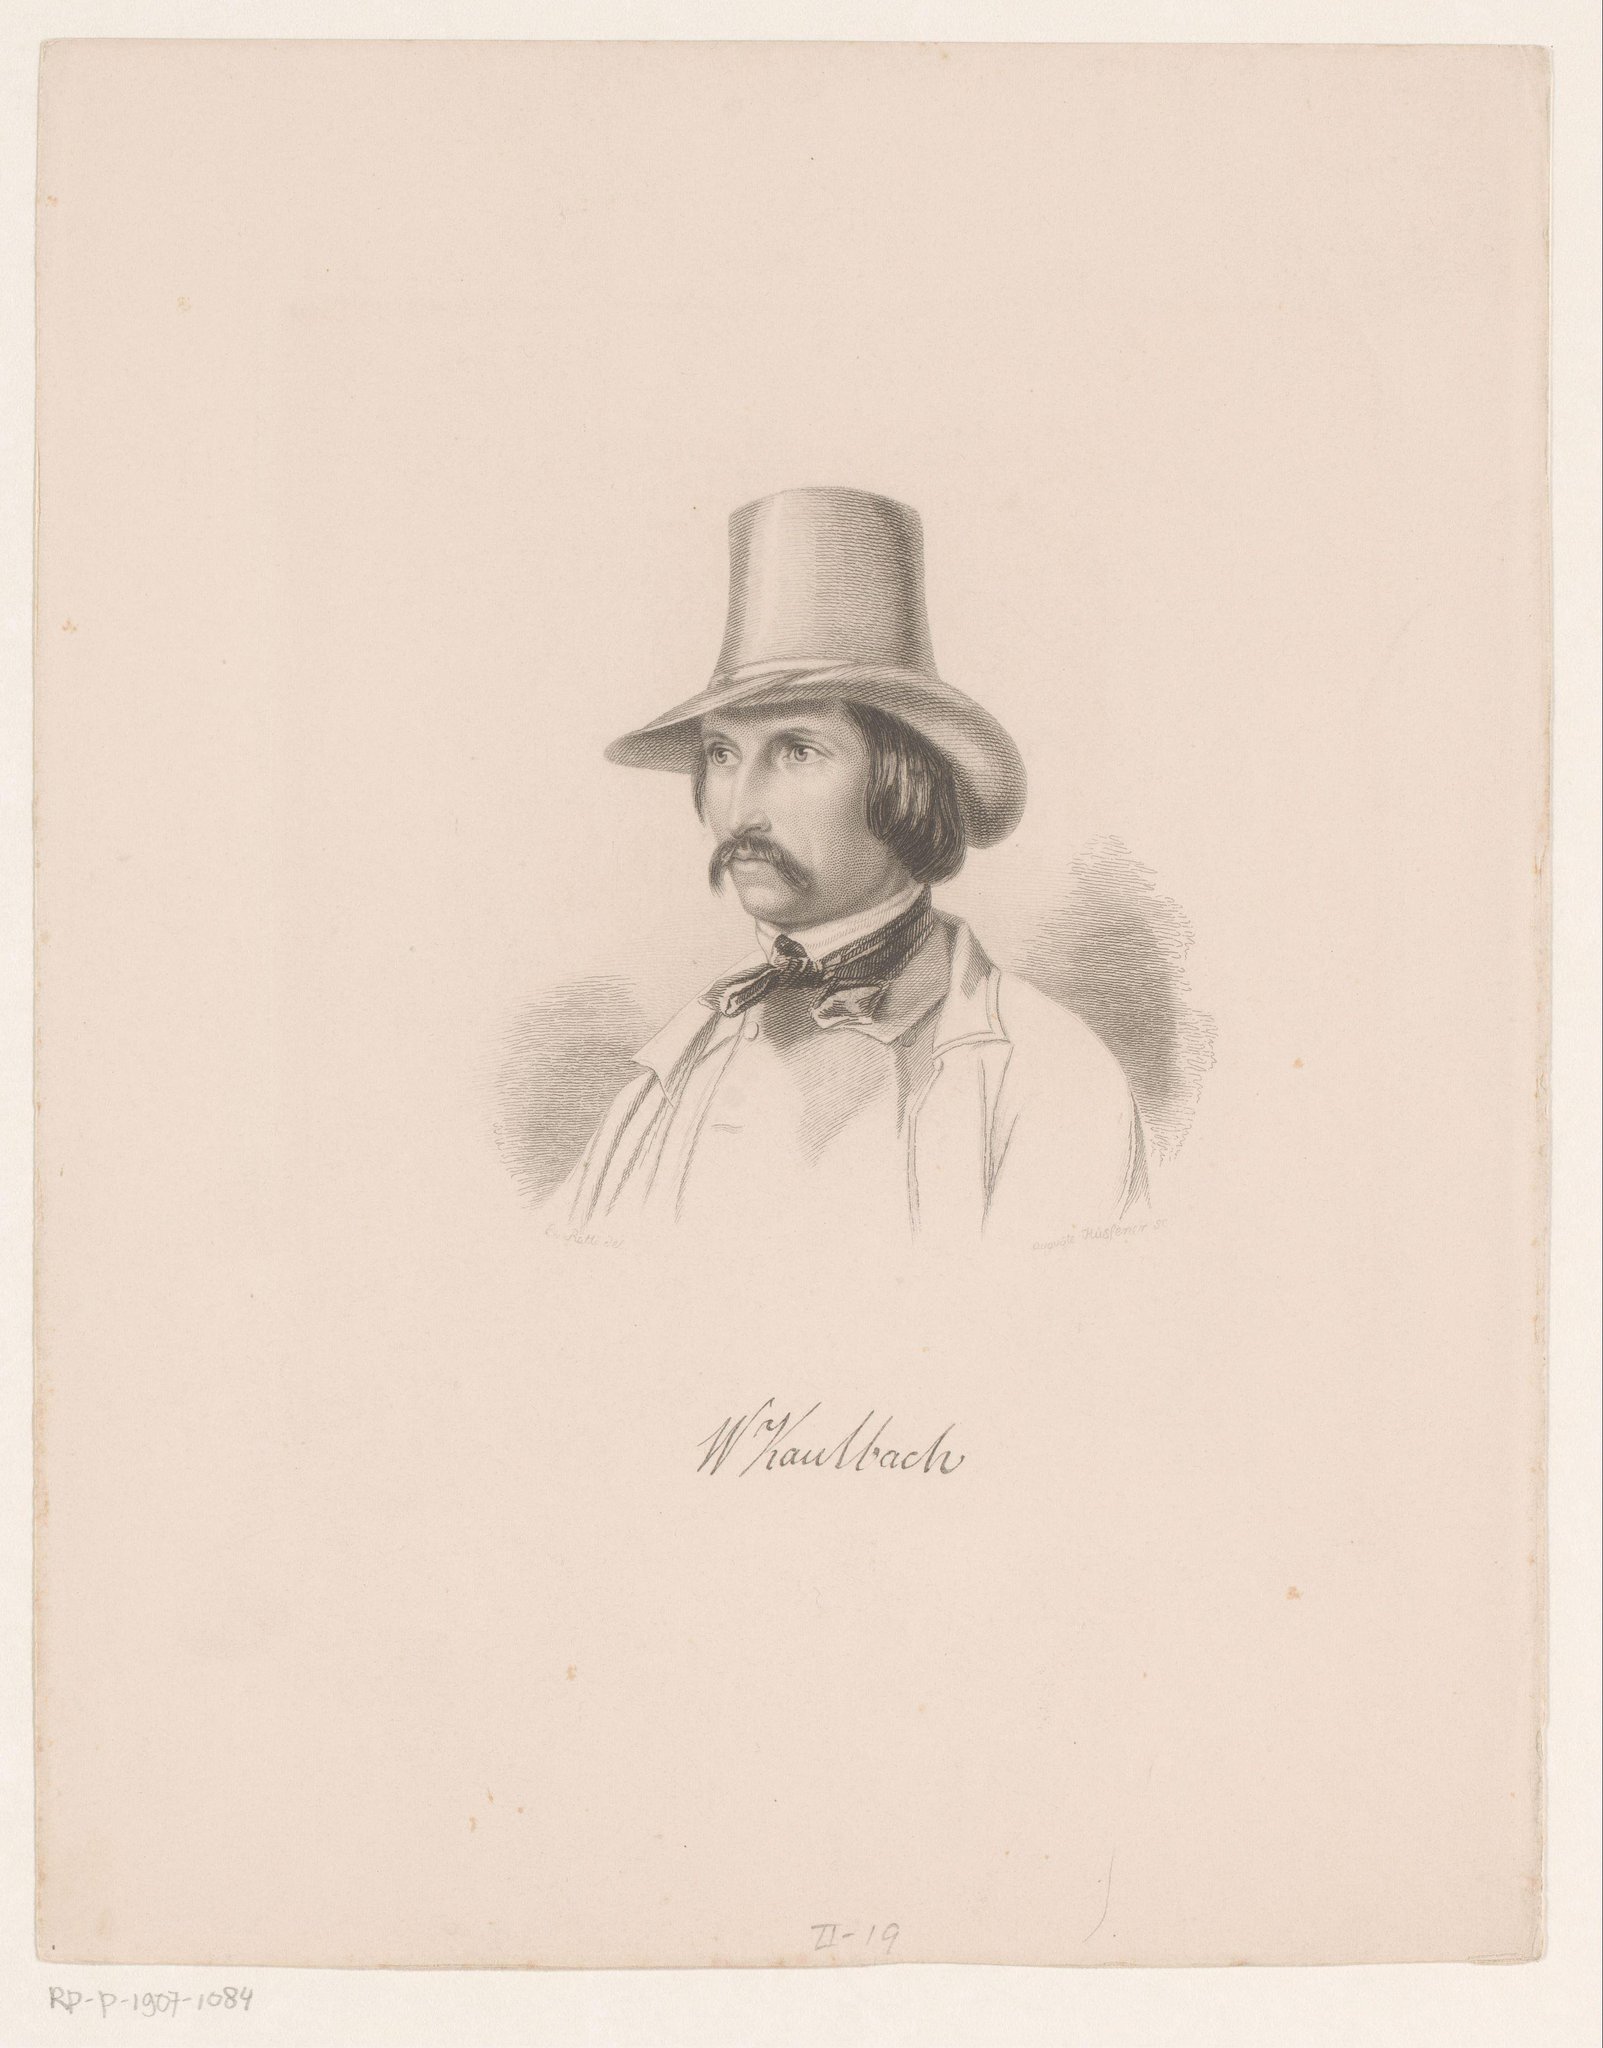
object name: print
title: Portret van Wilhelm von Kaulbach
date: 1826-1877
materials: paper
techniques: engraving, etching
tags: painter, draughtsman, wilhelm von kaulbach, historical persons, portrait, self-portrait of architect, portrait, self-portrait of painter, portrait, self-portrait of draughtsman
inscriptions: collector's mark: Lugt 2228